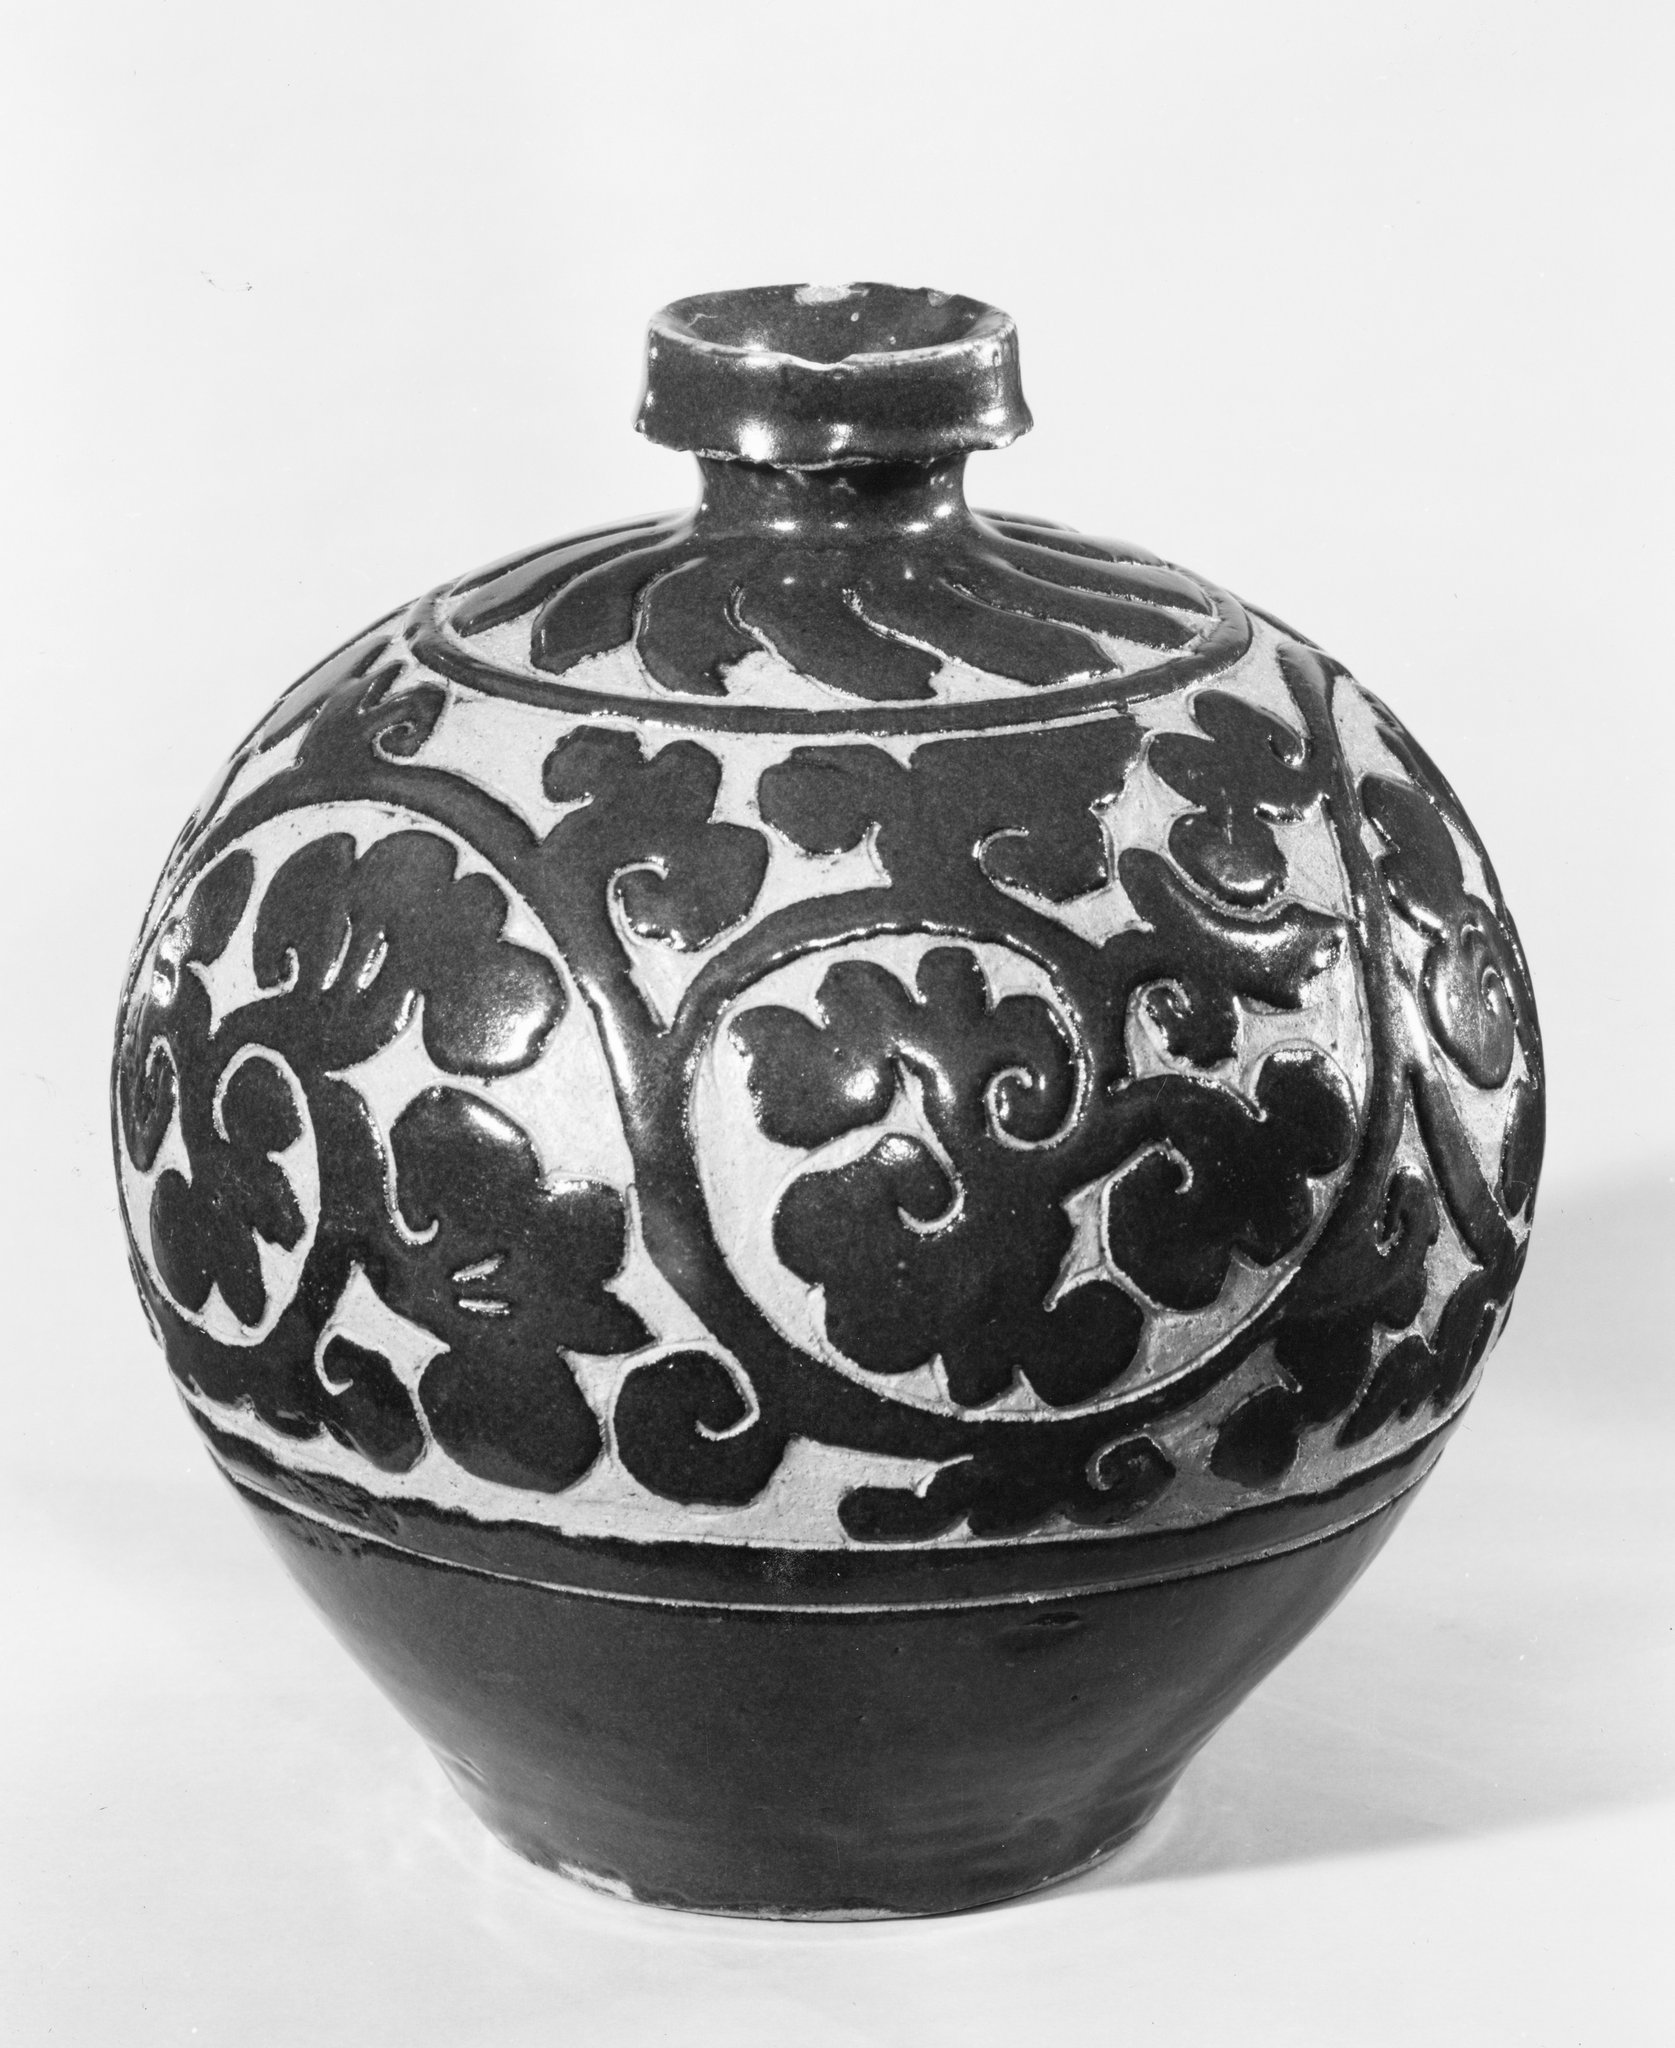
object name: bottle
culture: chinese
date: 1301-1400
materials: glaze, stoneware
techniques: cutting